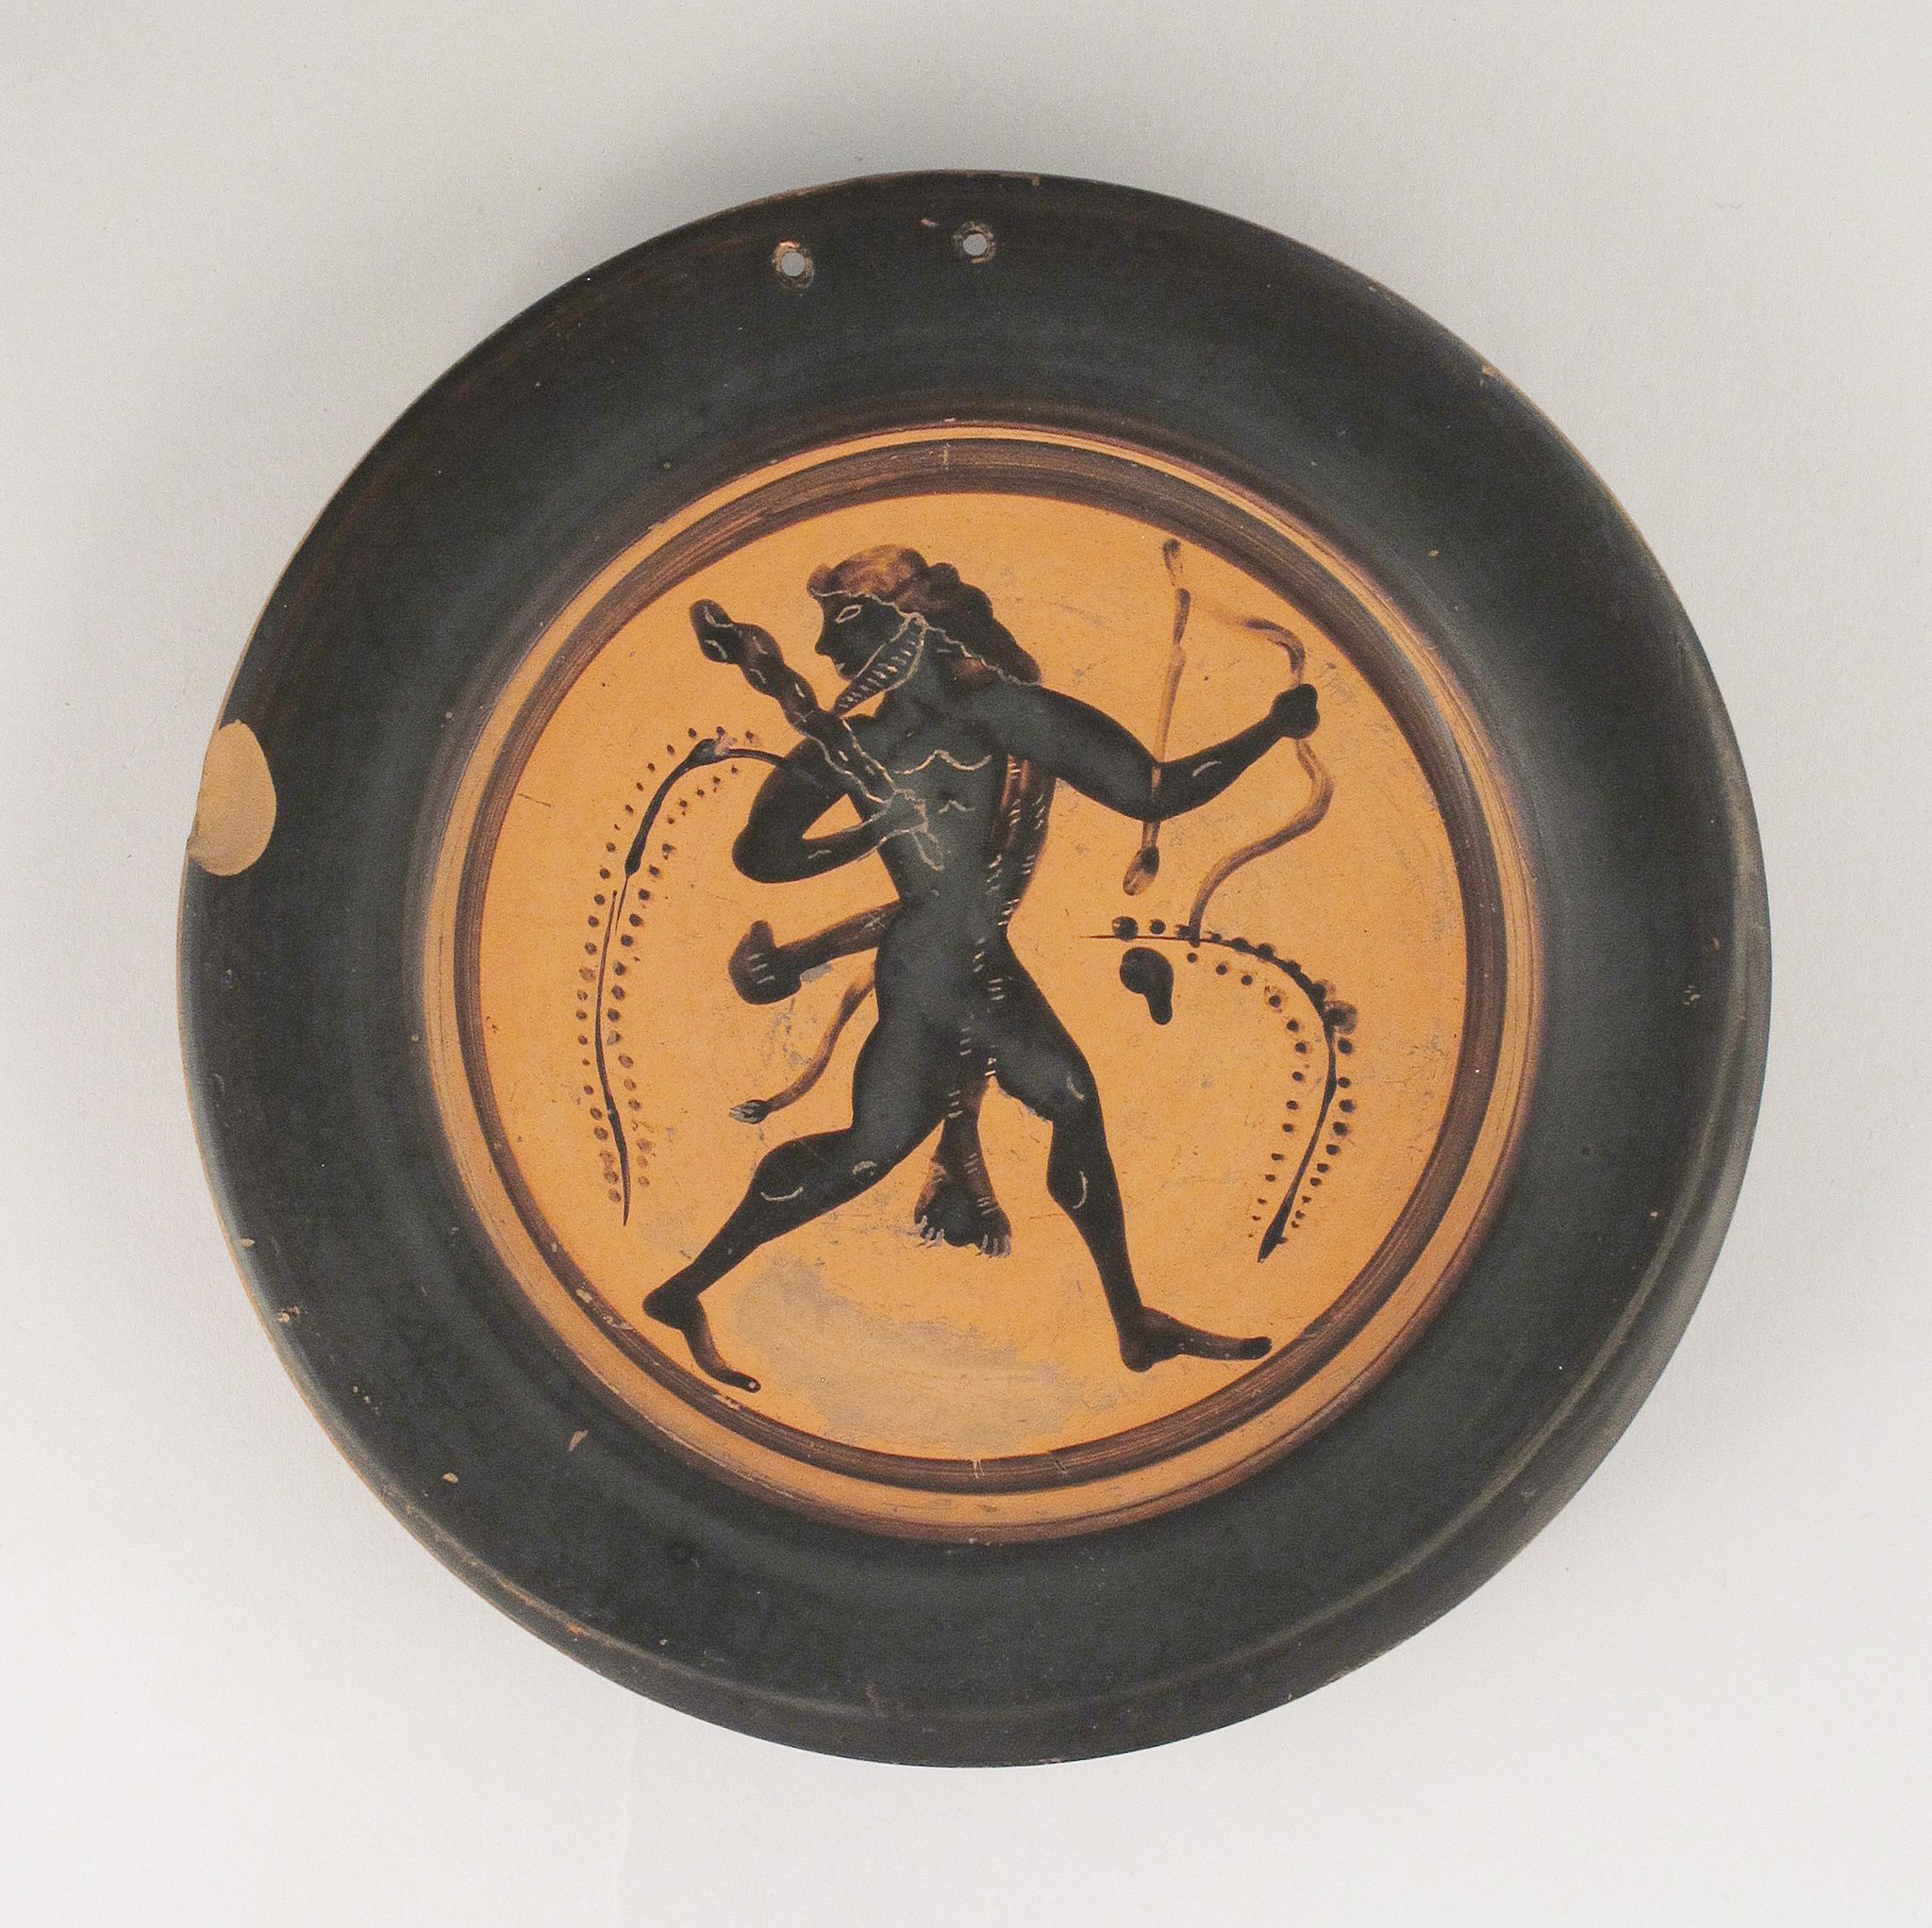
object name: plate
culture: greek, attic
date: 500 BCE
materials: terracotta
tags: herakles